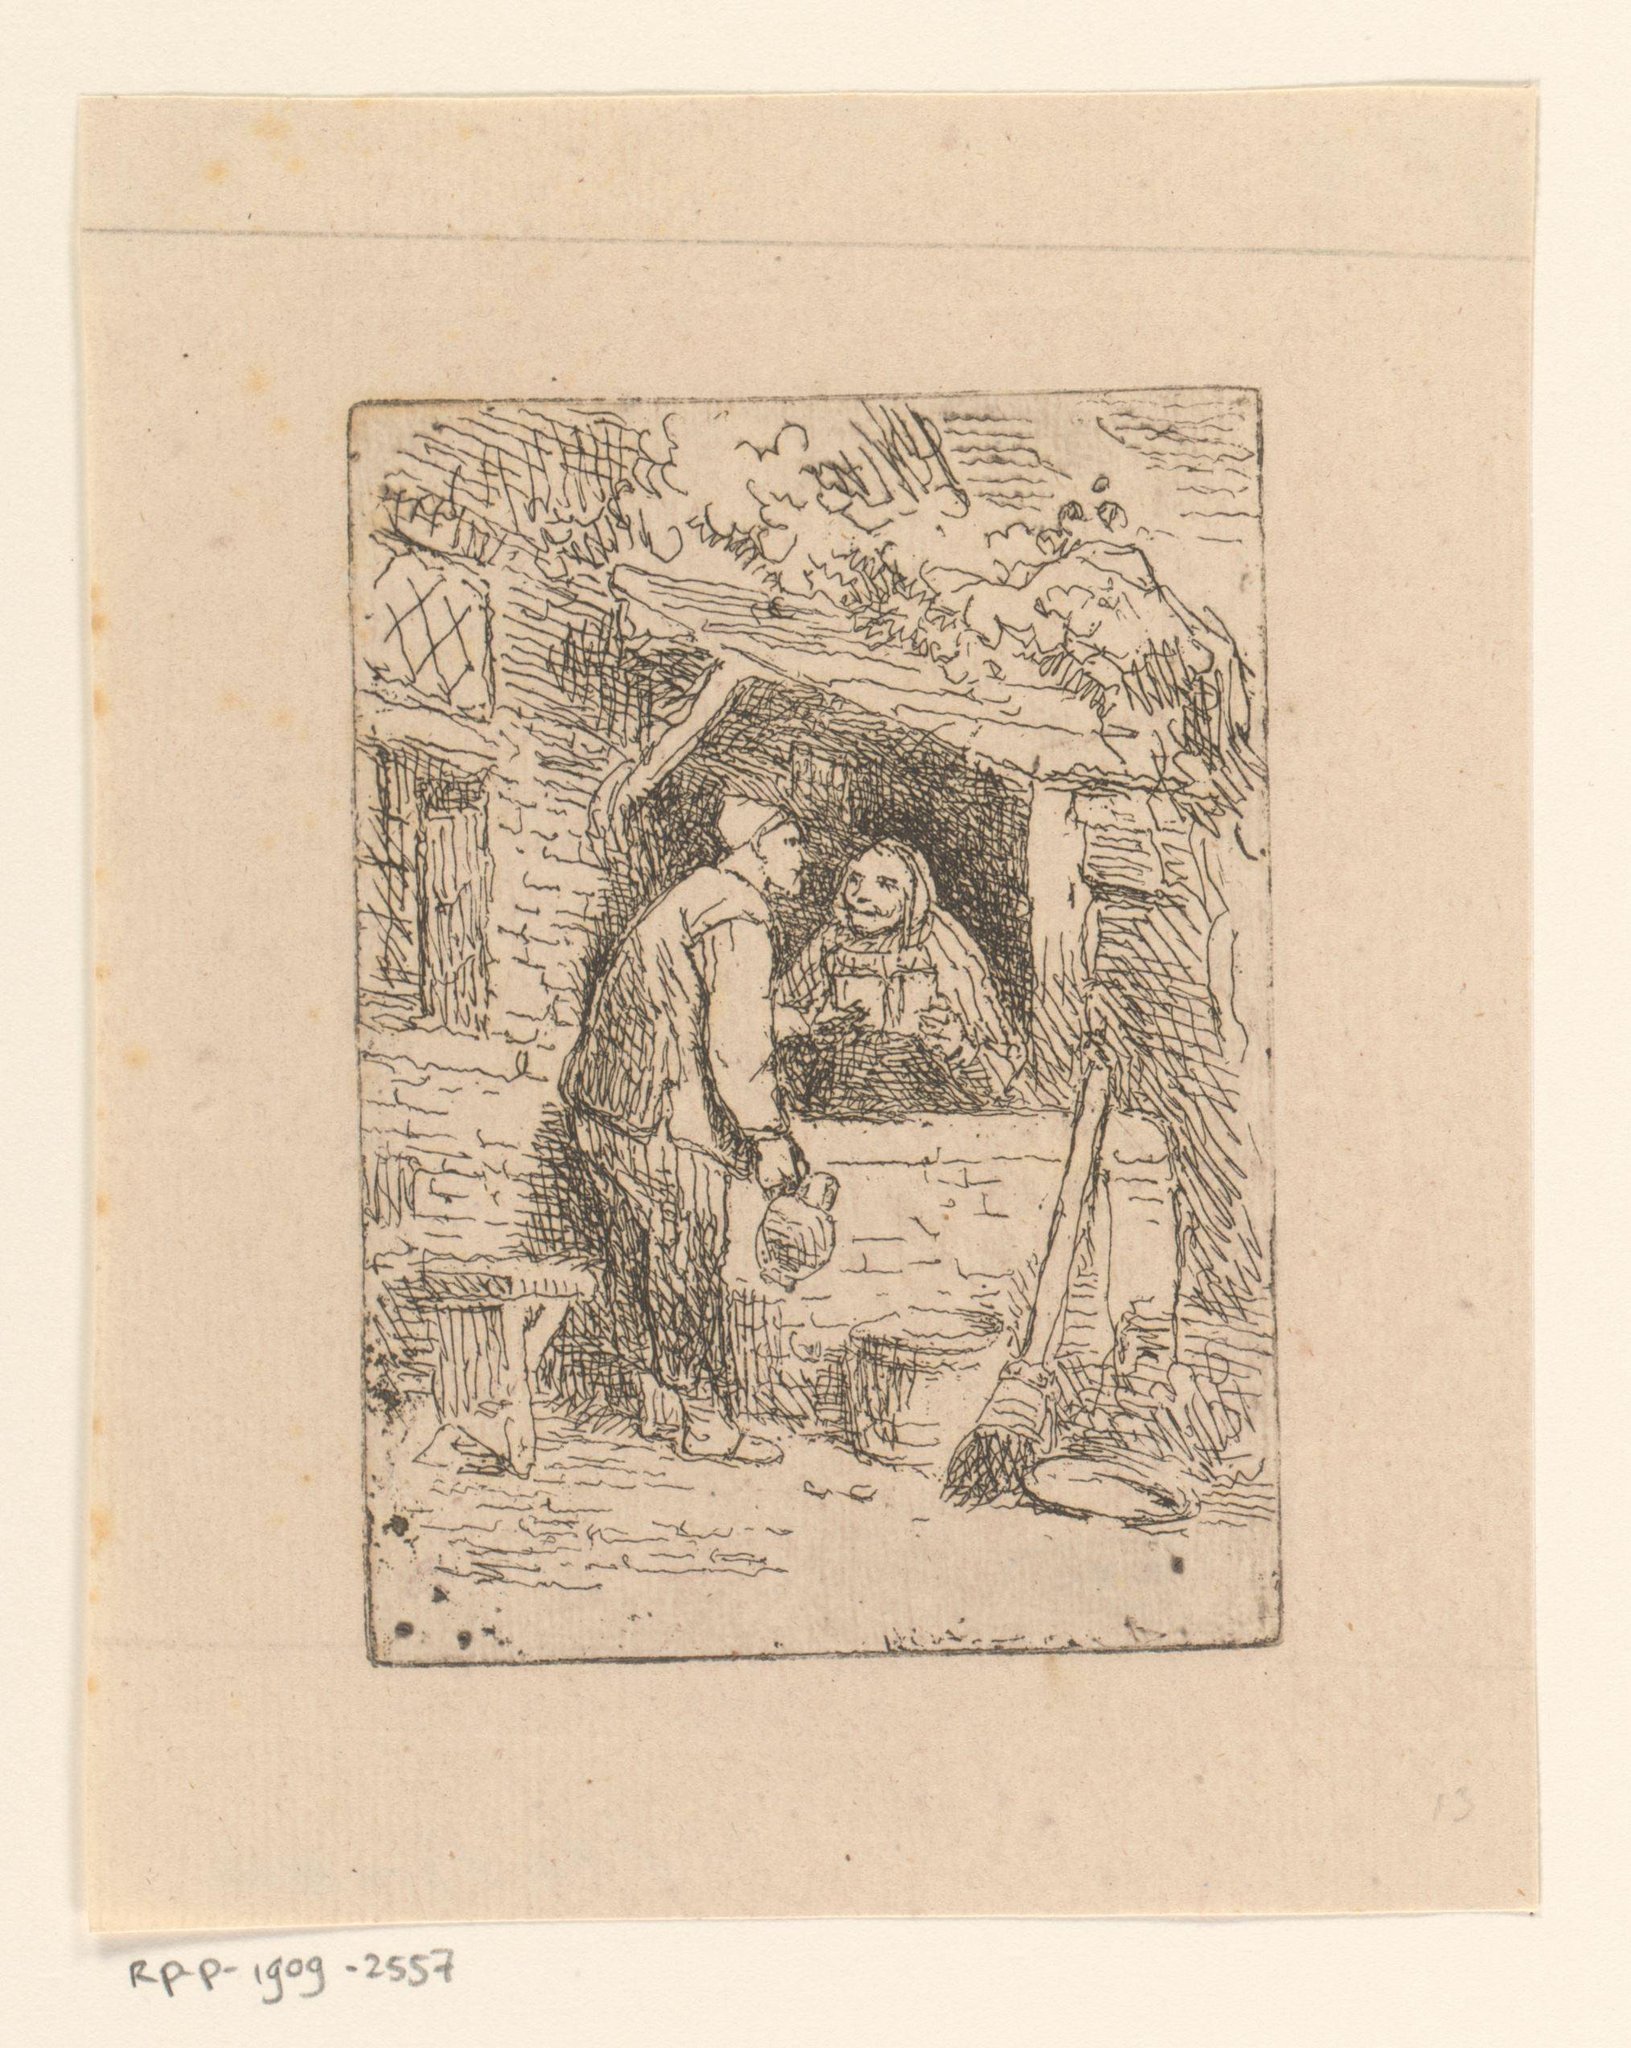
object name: print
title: Man en vrouw in gesprek bij een huis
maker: ferdinand de braekeleer (i)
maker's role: draughtsman, print maker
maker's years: 1792-1883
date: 1802-1883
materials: paper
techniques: etching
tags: housing, conversation, dialogue; conversation piece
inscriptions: collector's mark: Lugt 2228